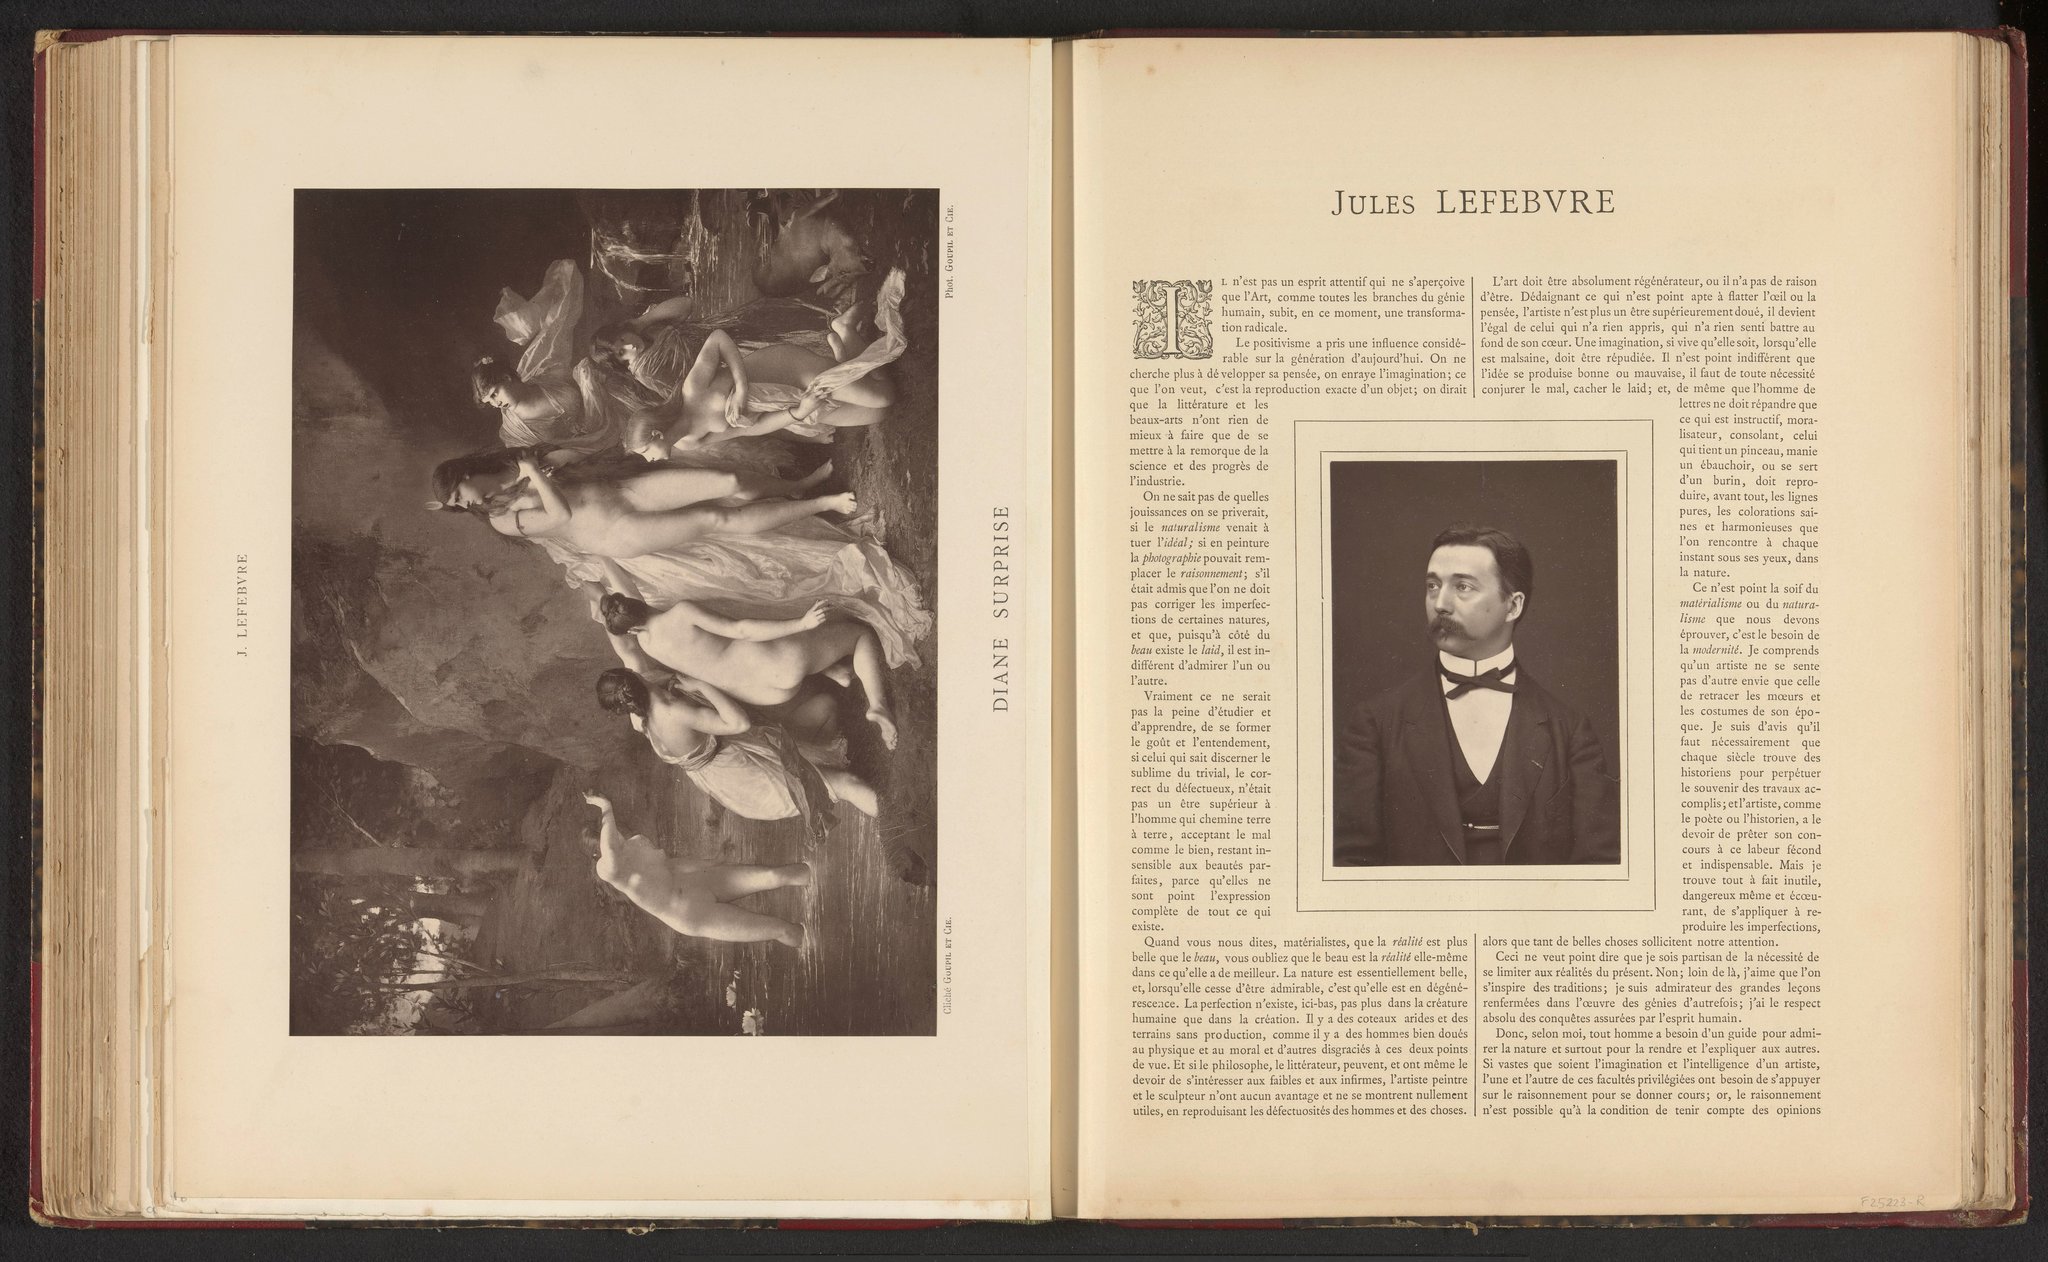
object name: photomechanical print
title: Portret van Jules Joseph Lefebvre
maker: Anonymous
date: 1876-1879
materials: paper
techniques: woodburytype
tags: portrait, self-portrait of painter